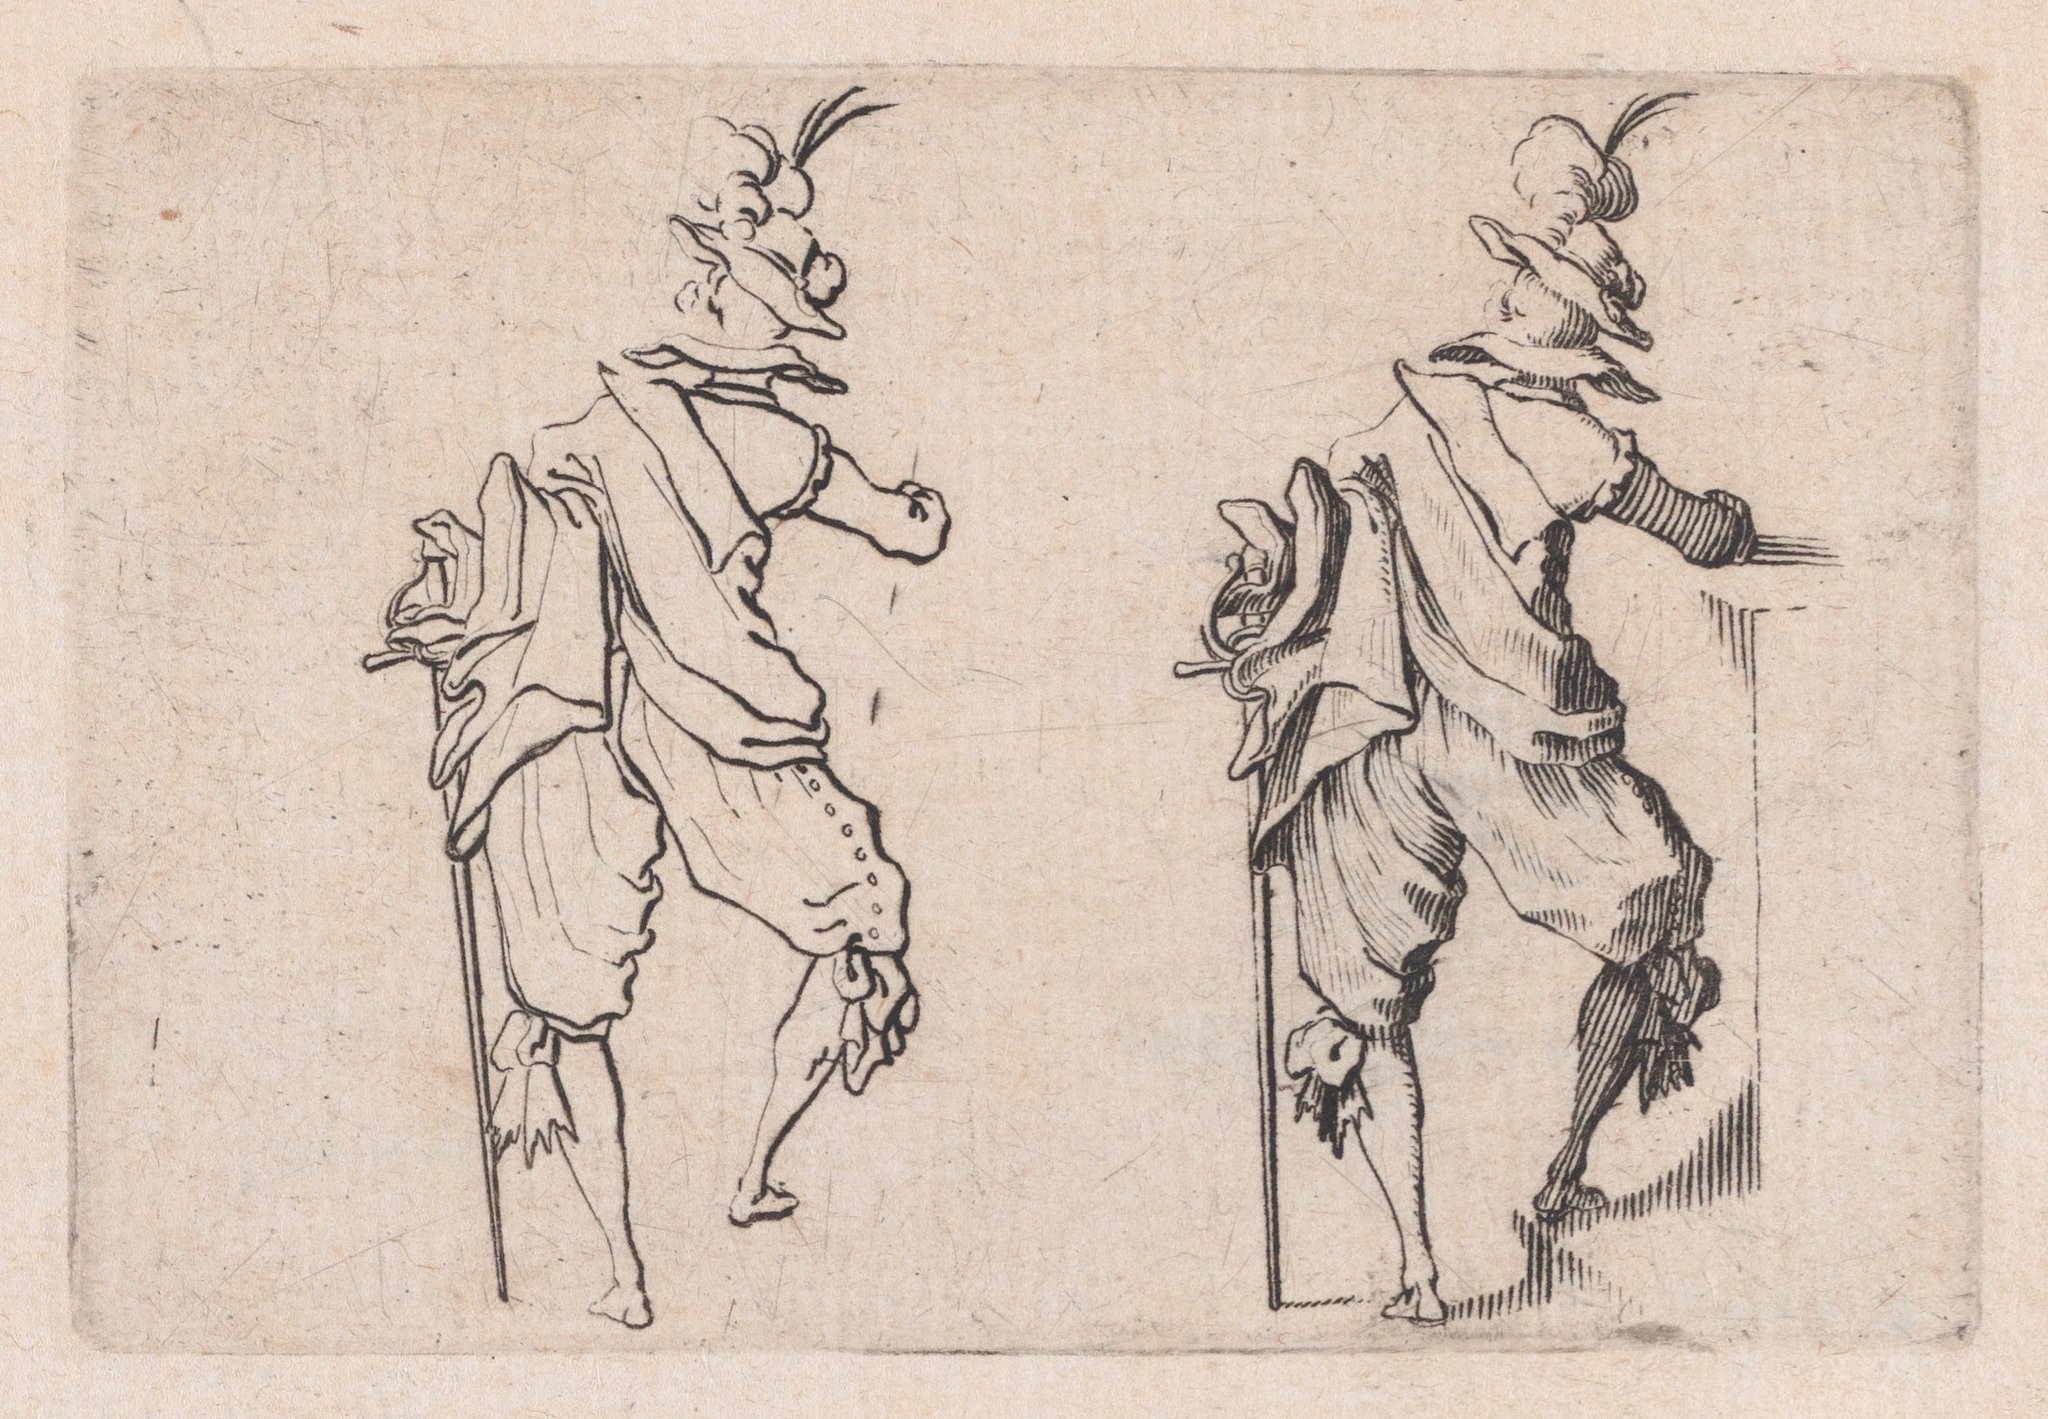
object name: print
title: L'Homme Vu de Dos, Avec une Grande Épée (Man Viewed from Behind, with a Large Sword), from "Les Caprices" Series B, The Nancy Set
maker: jacques callot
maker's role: artist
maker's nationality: french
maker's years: 1592-1635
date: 1617-1620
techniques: etching